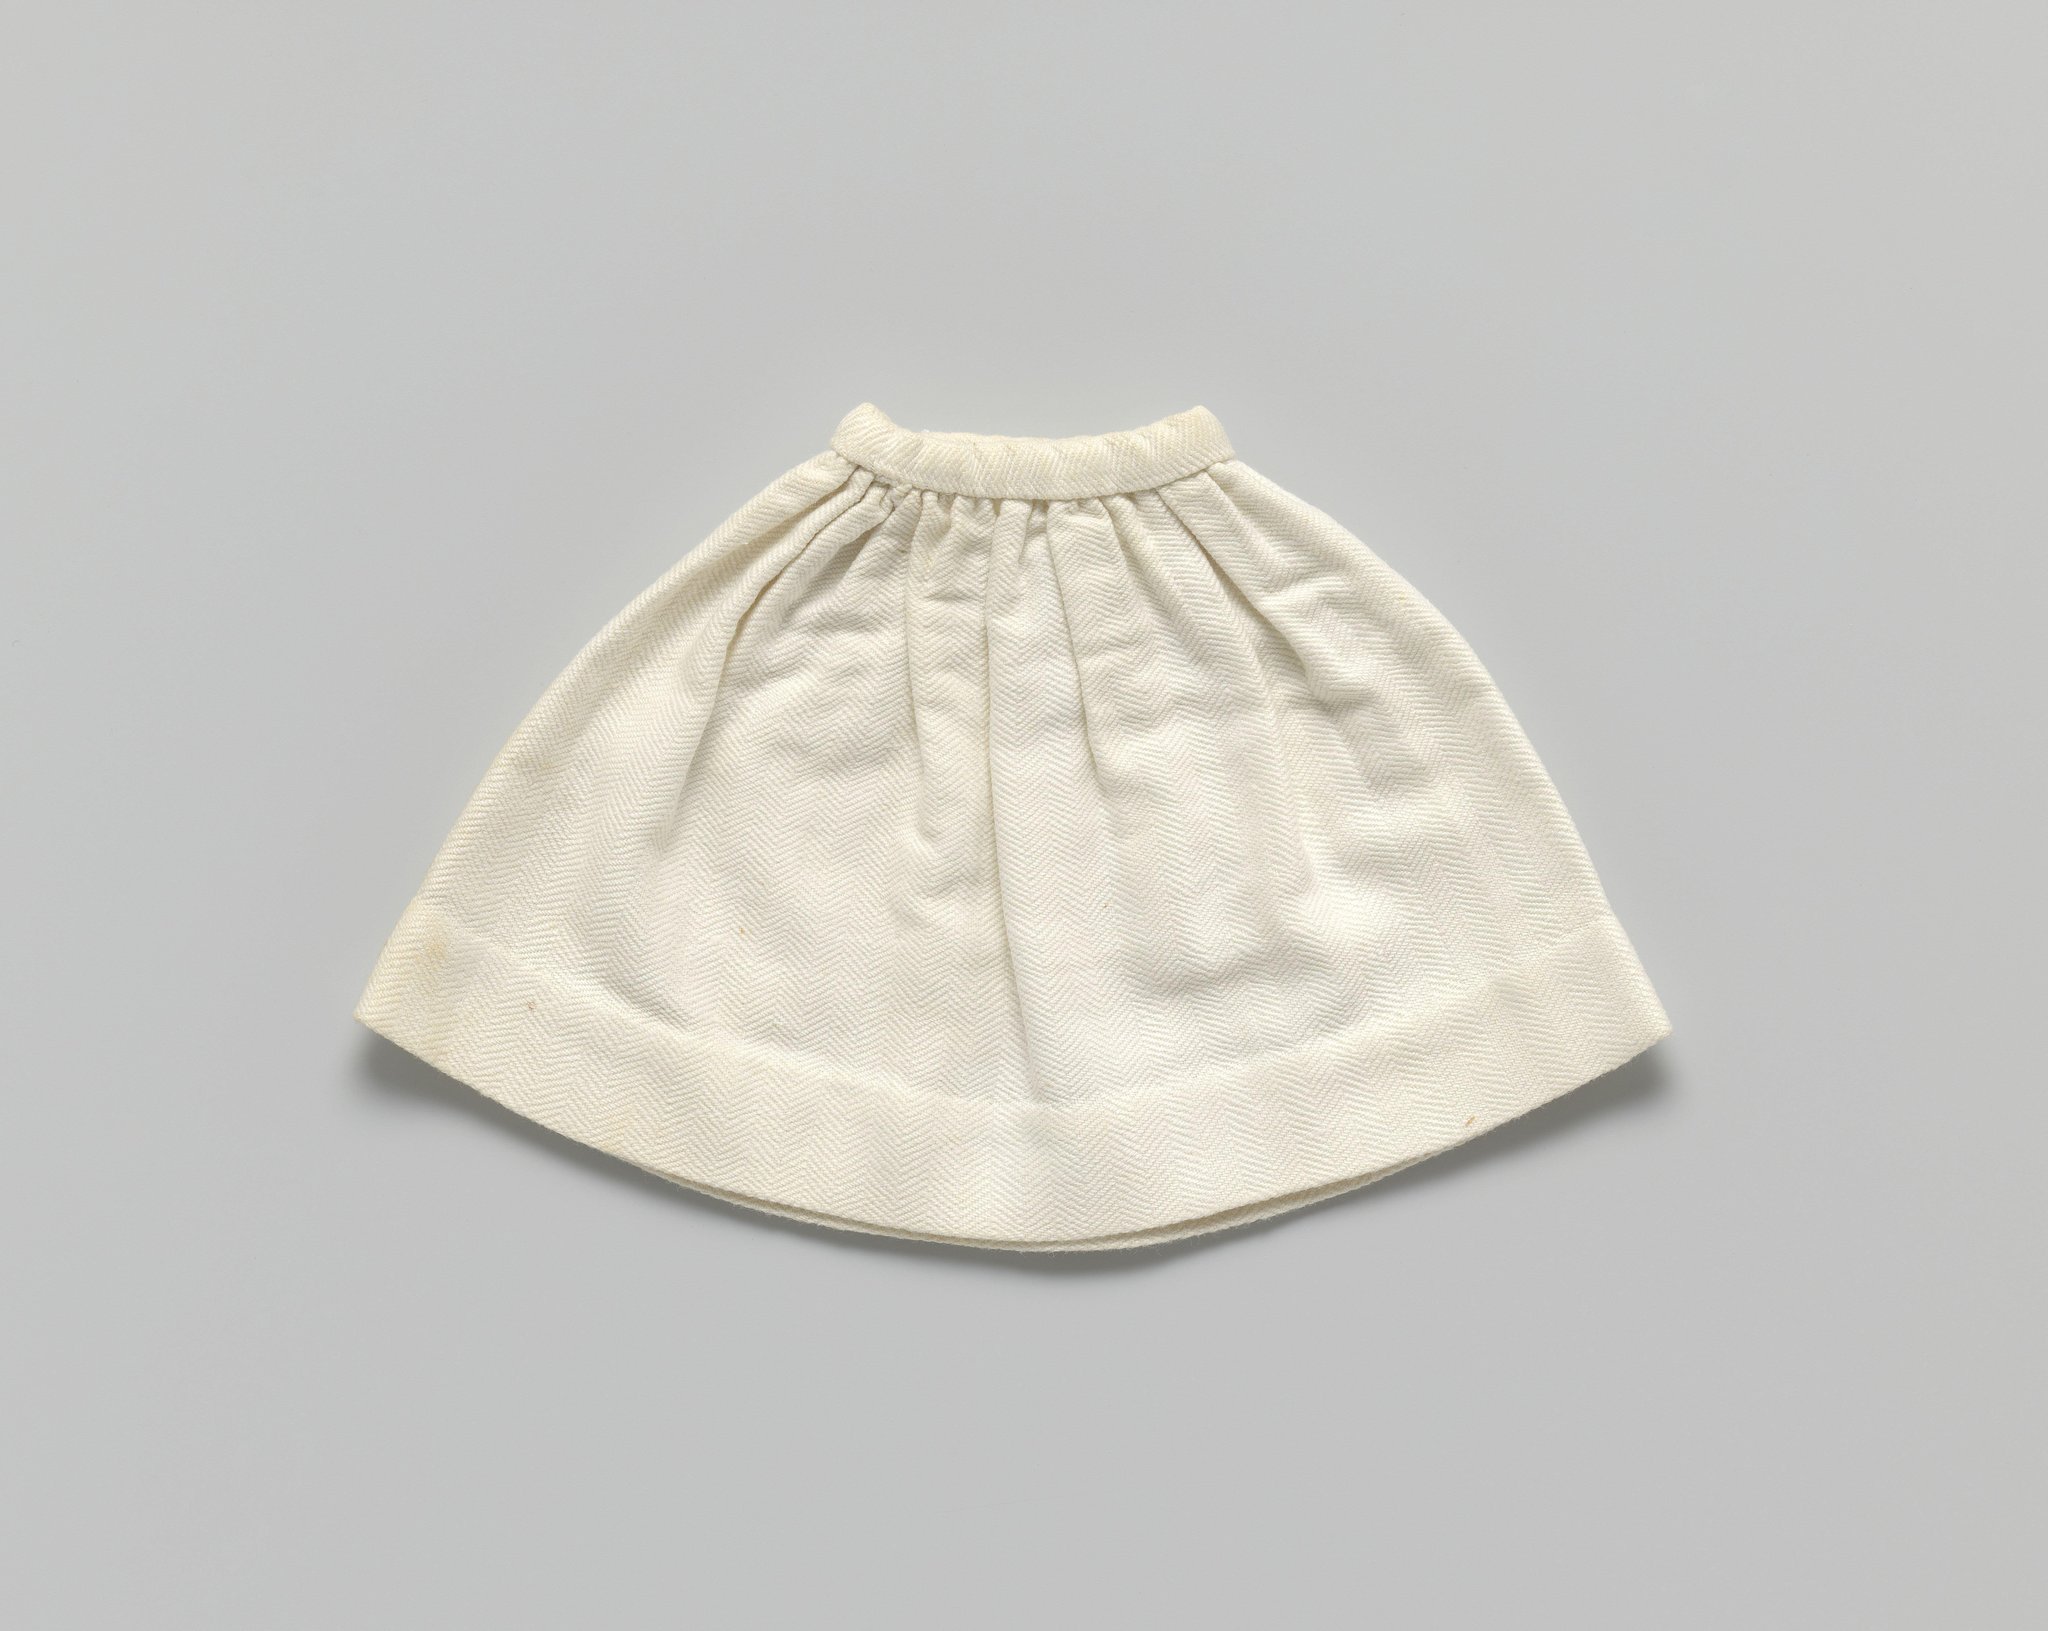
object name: underskirt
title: Onderrok van wit katoen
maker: Anonymous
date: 1850-1920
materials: cotton, metal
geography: europe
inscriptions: number: ‘RBK15445’